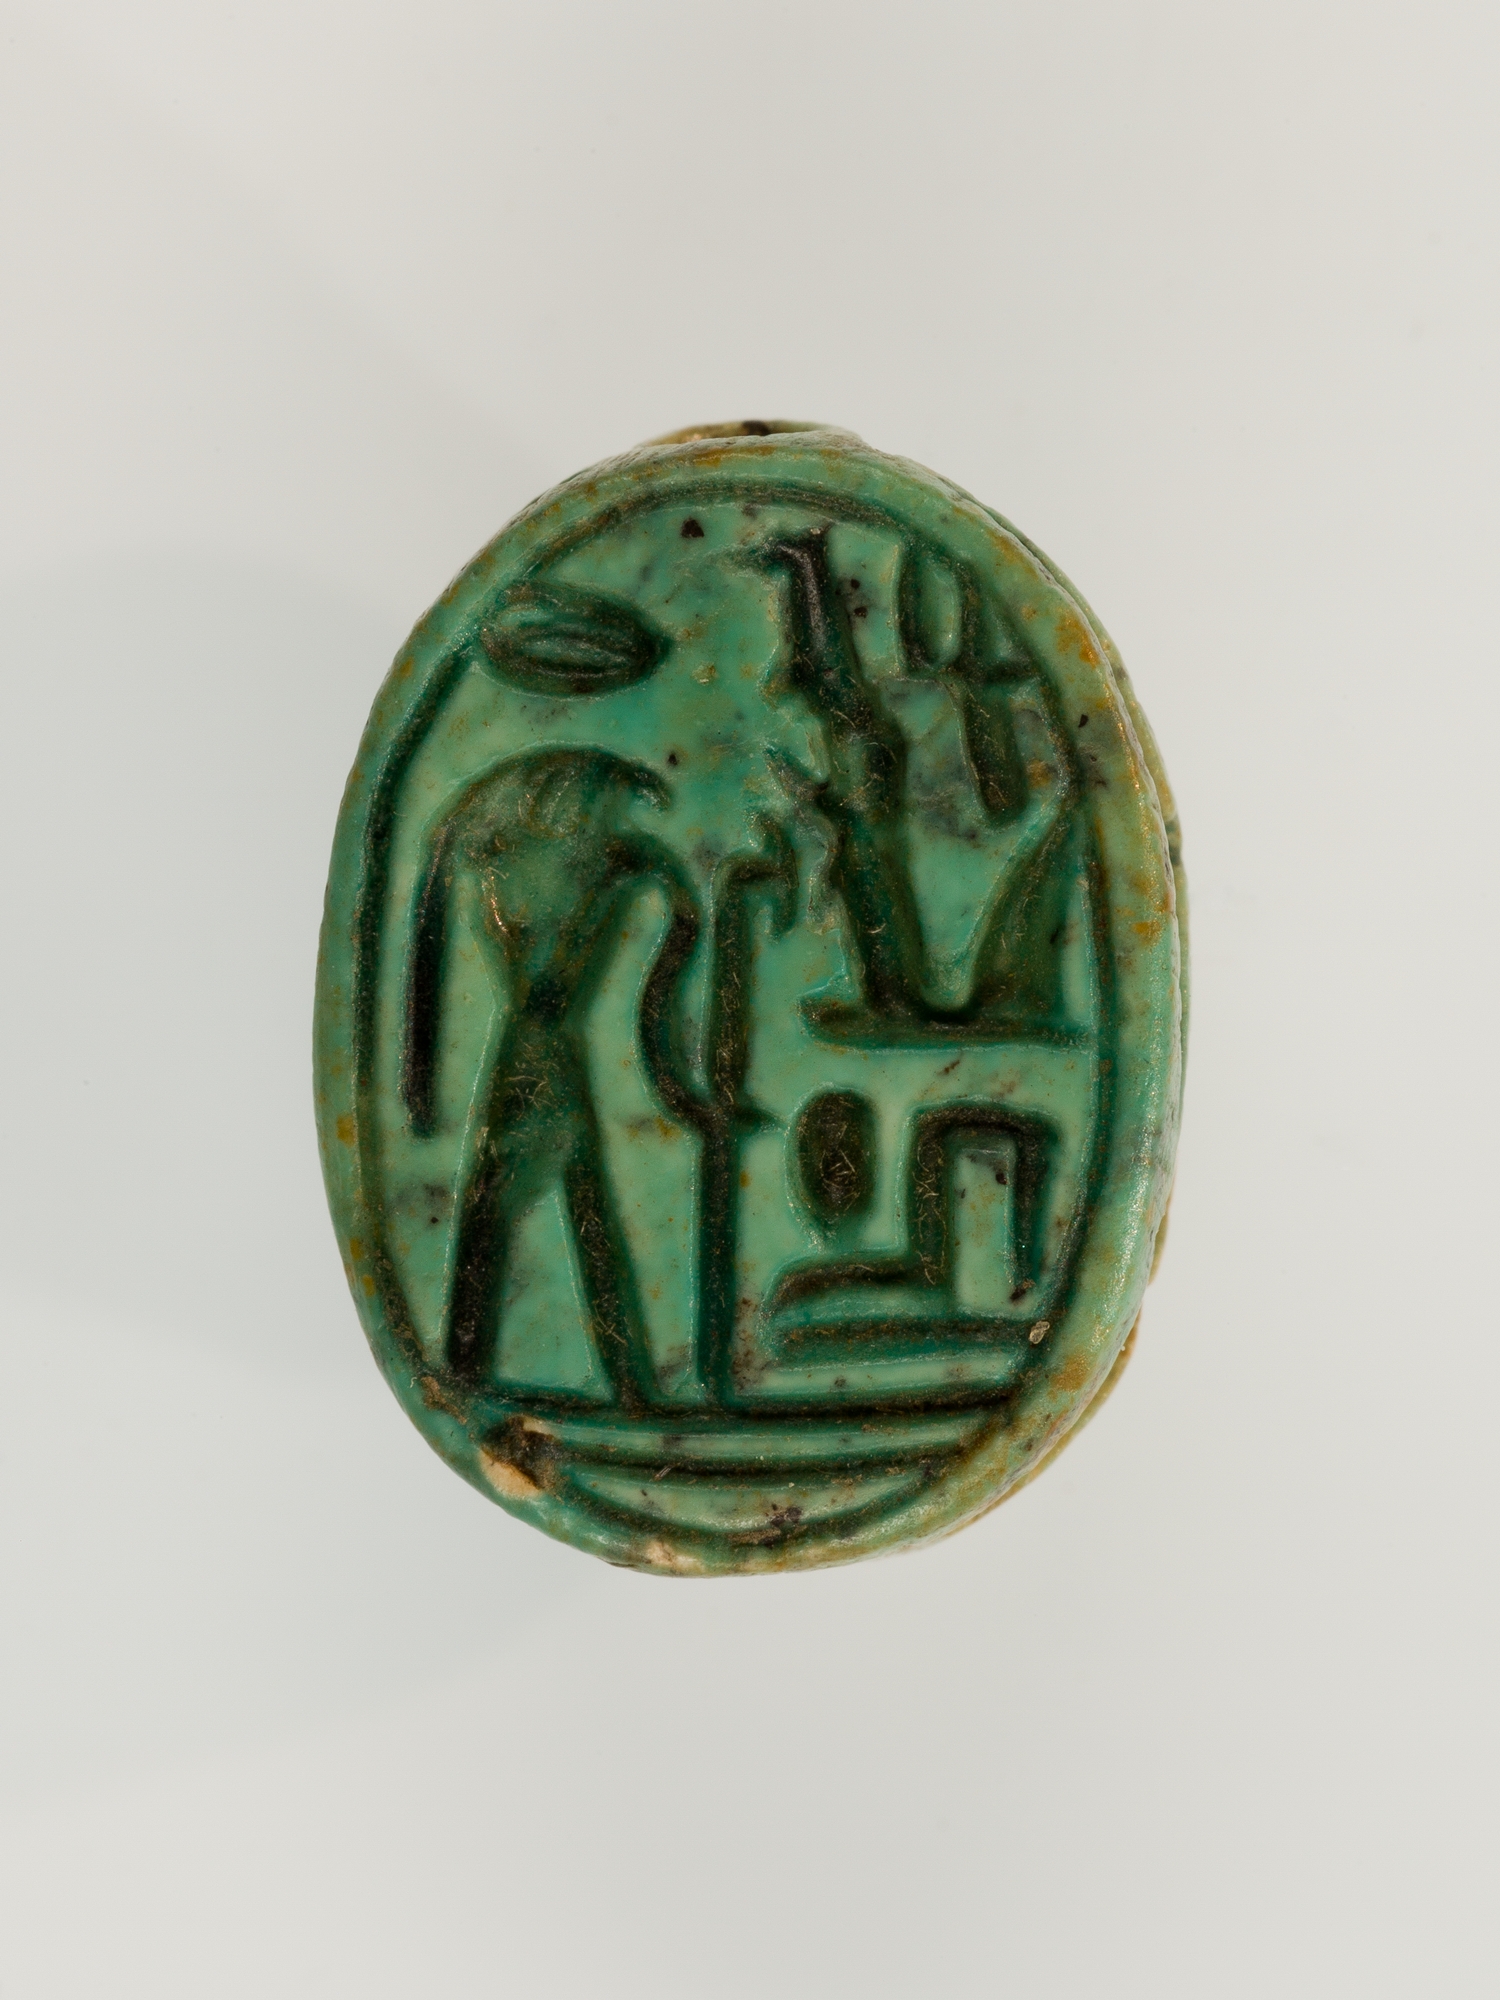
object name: scarab, ramesses ii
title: Scarab of Ramesses II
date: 1295-1070 BCE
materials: stone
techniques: glazing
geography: egypt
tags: hieroglyphs,scarabs